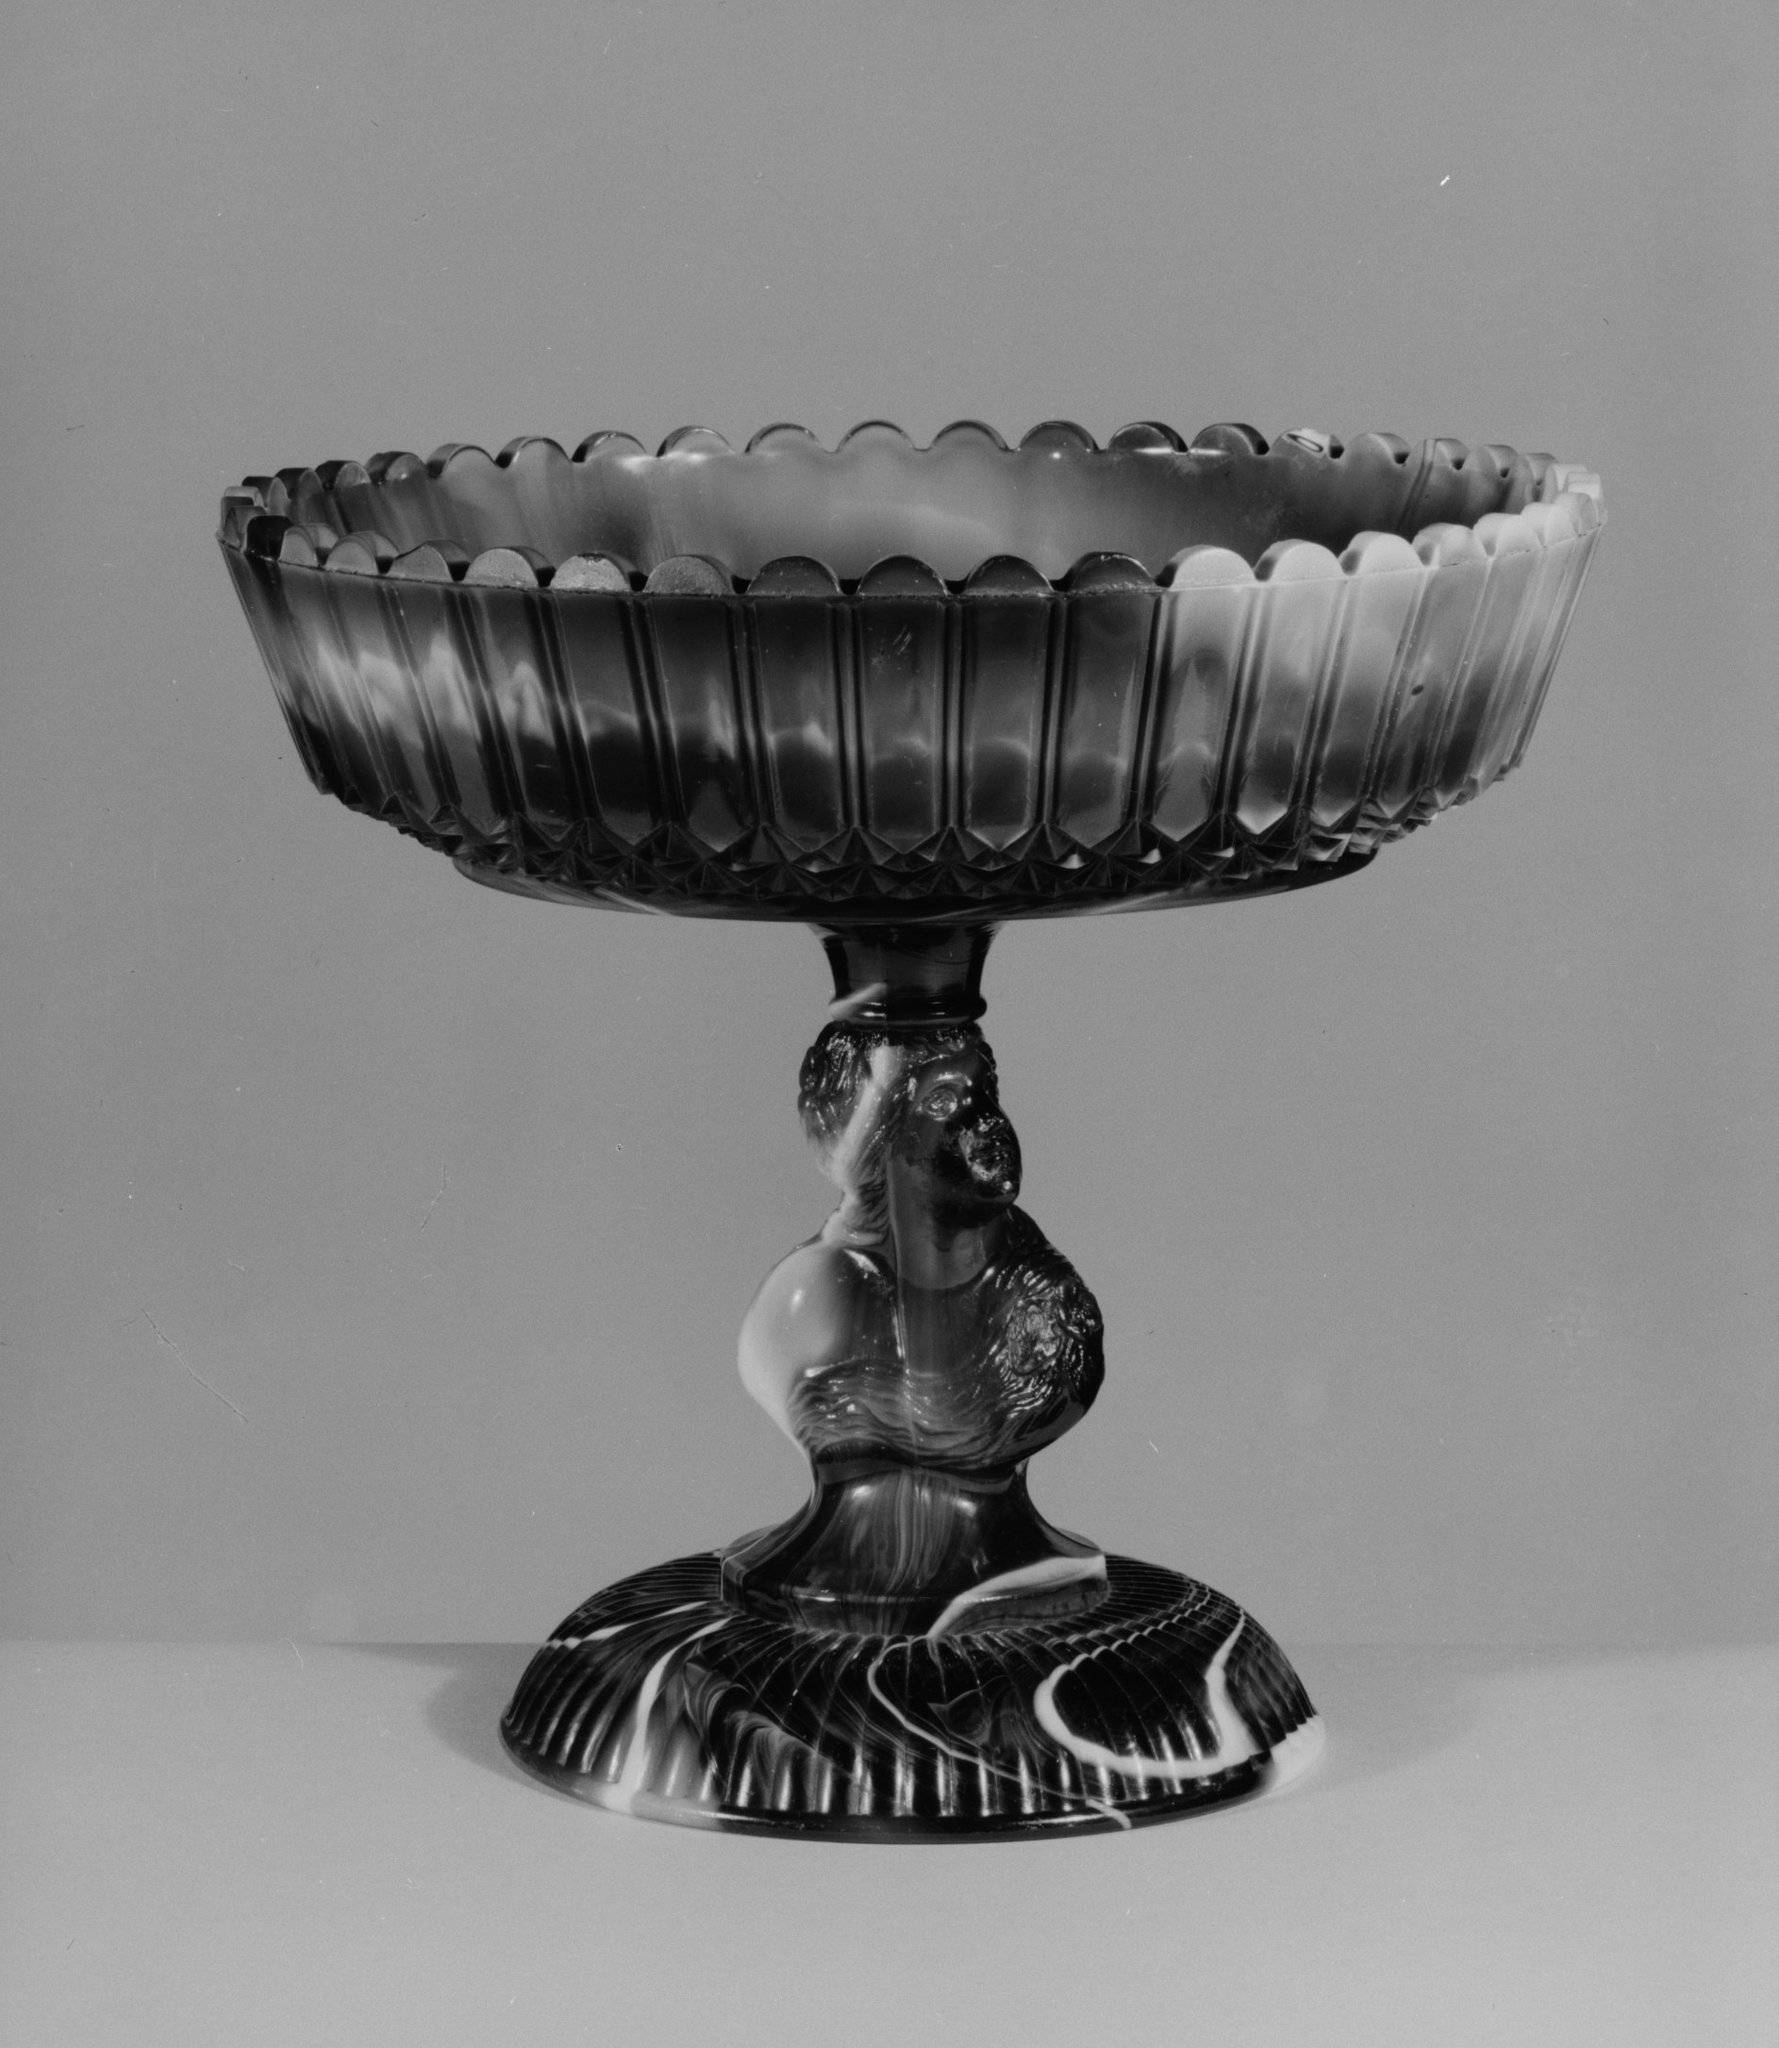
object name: compote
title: Purple marble glass compote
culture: american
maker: challinor, taylor and company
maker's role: maker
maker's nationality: american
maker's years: 1866-1891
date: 1870-1890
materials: glass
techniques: pressed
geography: united states